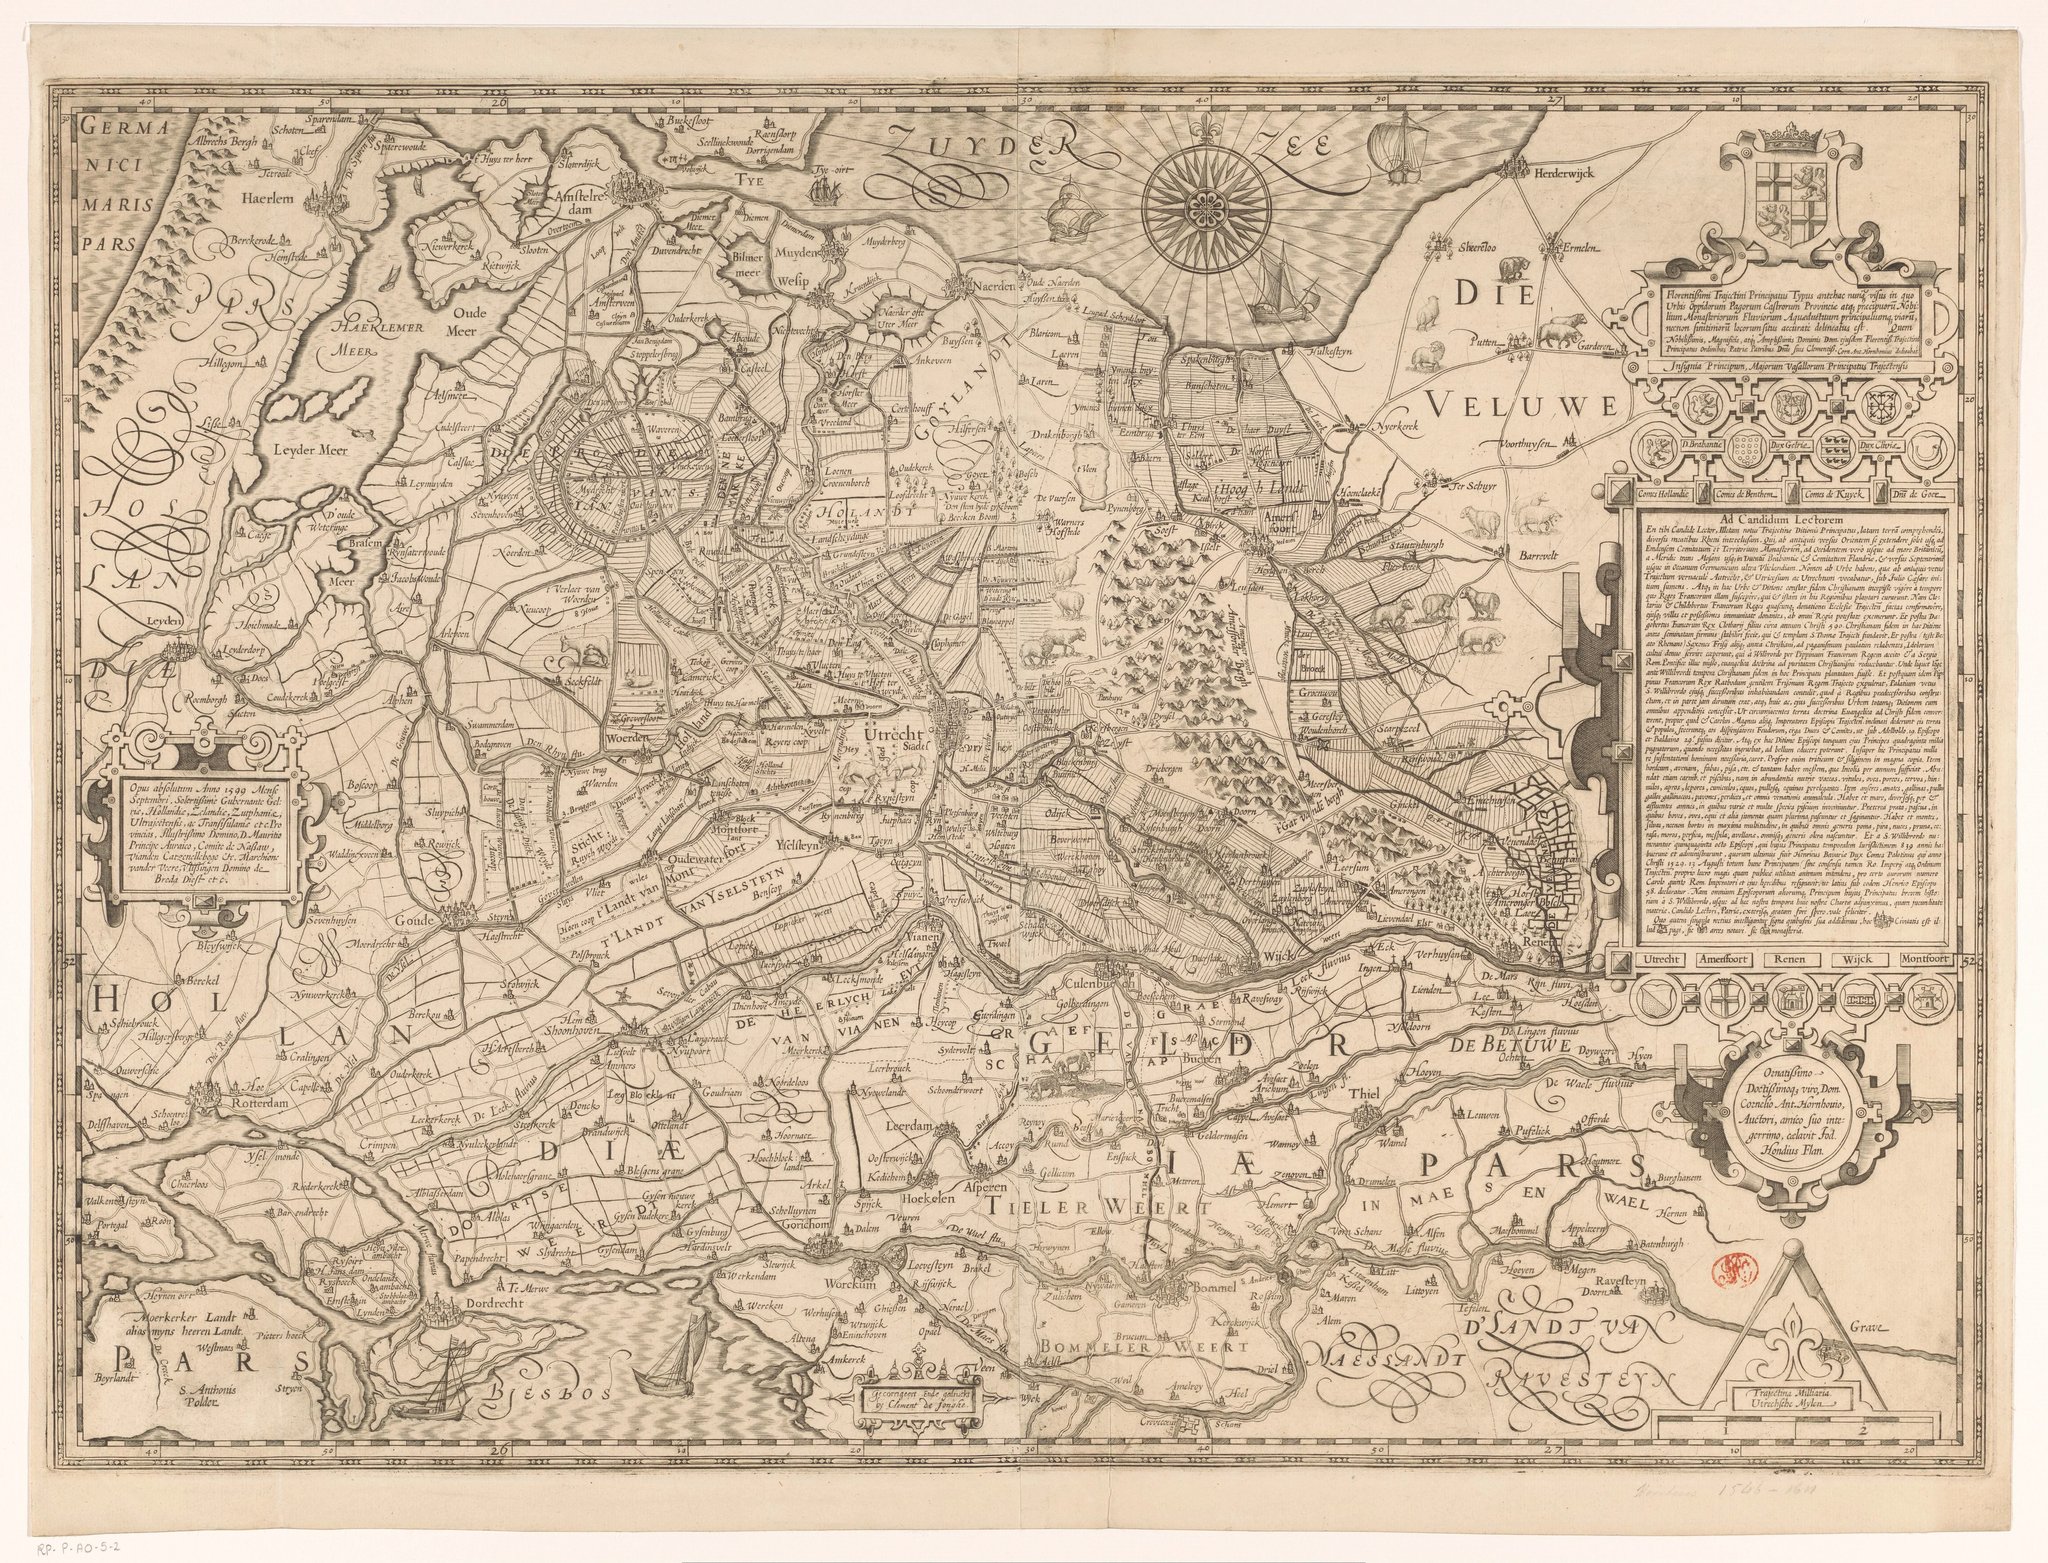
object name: print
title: Florentissimi trajectini principatus typus antehac nunq visus in quo urbis oppidorum pagorum (...)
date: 1643-1677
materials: paper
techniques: engraving, etching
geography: amsterdam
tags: coat of arms (as symbol of the state, etc.), maps of separate countries or regions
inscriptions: collector's mark: Lugt 195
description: Links in het midden een cartouche met de opdracht. Rechtsboven de titelcartouche met het wapen van de provincie Utrecht. Daaronder de wapens van de hertogdommen Brabant, Gelderland en Kleef. Daaronder de wapens de graafschappen Holland, Bentheim en Cuijk, en nog een wapen met een bazuin. Daaronder een uitgebreide historische en geografische beschrijving van de provincie Utrecht met een legenda. Daaronder de wapens van de steden Utrecht, Amersfoort, Rhenen, Wijk bij Duurstede en Montfoort. Rechtsonder een schaalstok: Trajectina milliaria / Utrechtsche mylen. Gradenverdeling langs de randen.